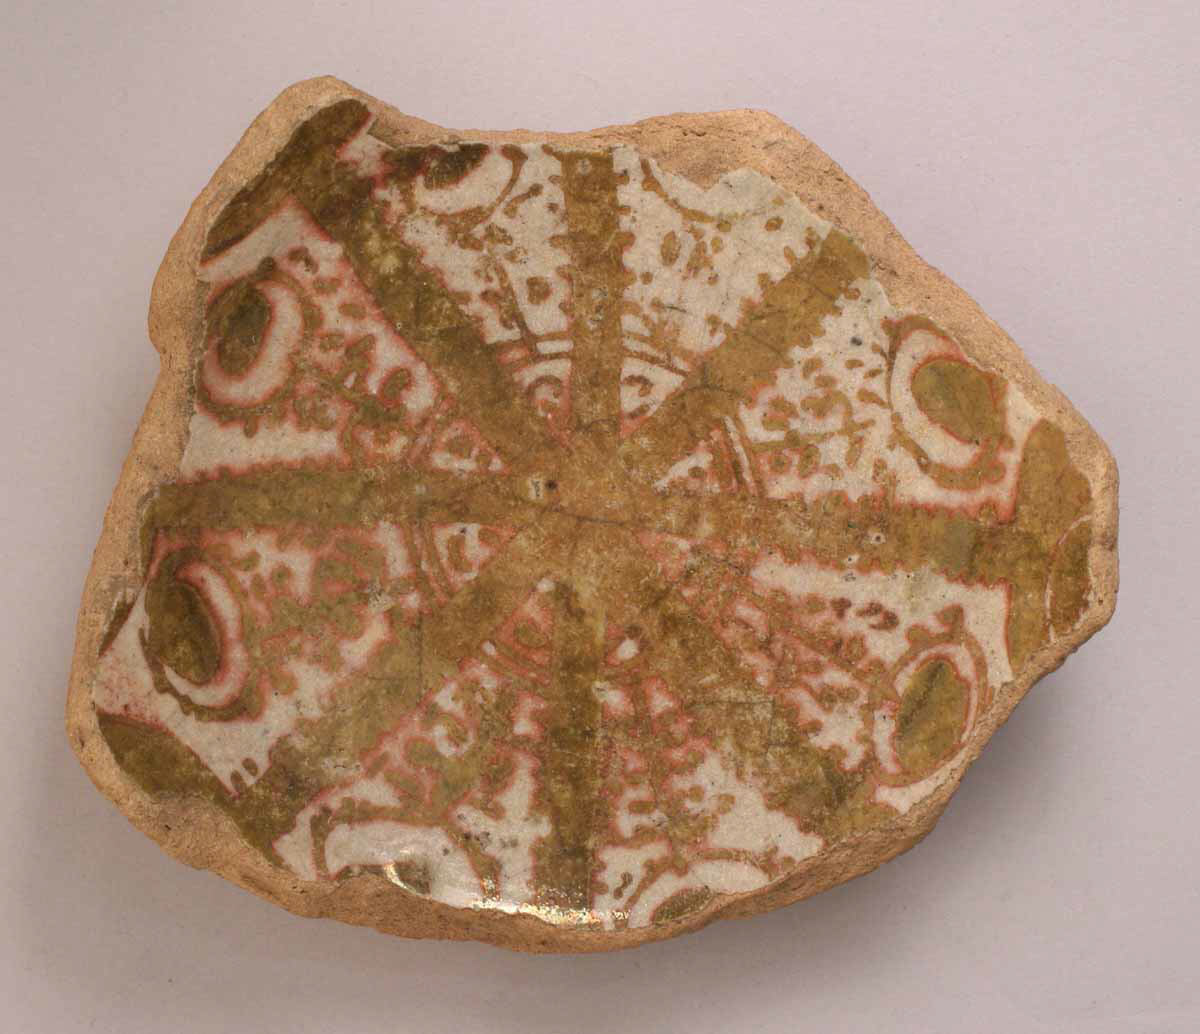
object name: fragment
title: Fragment of a Bowl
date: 1101-1200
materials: earthenware, tin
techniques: enamel, luster painting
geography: egypt